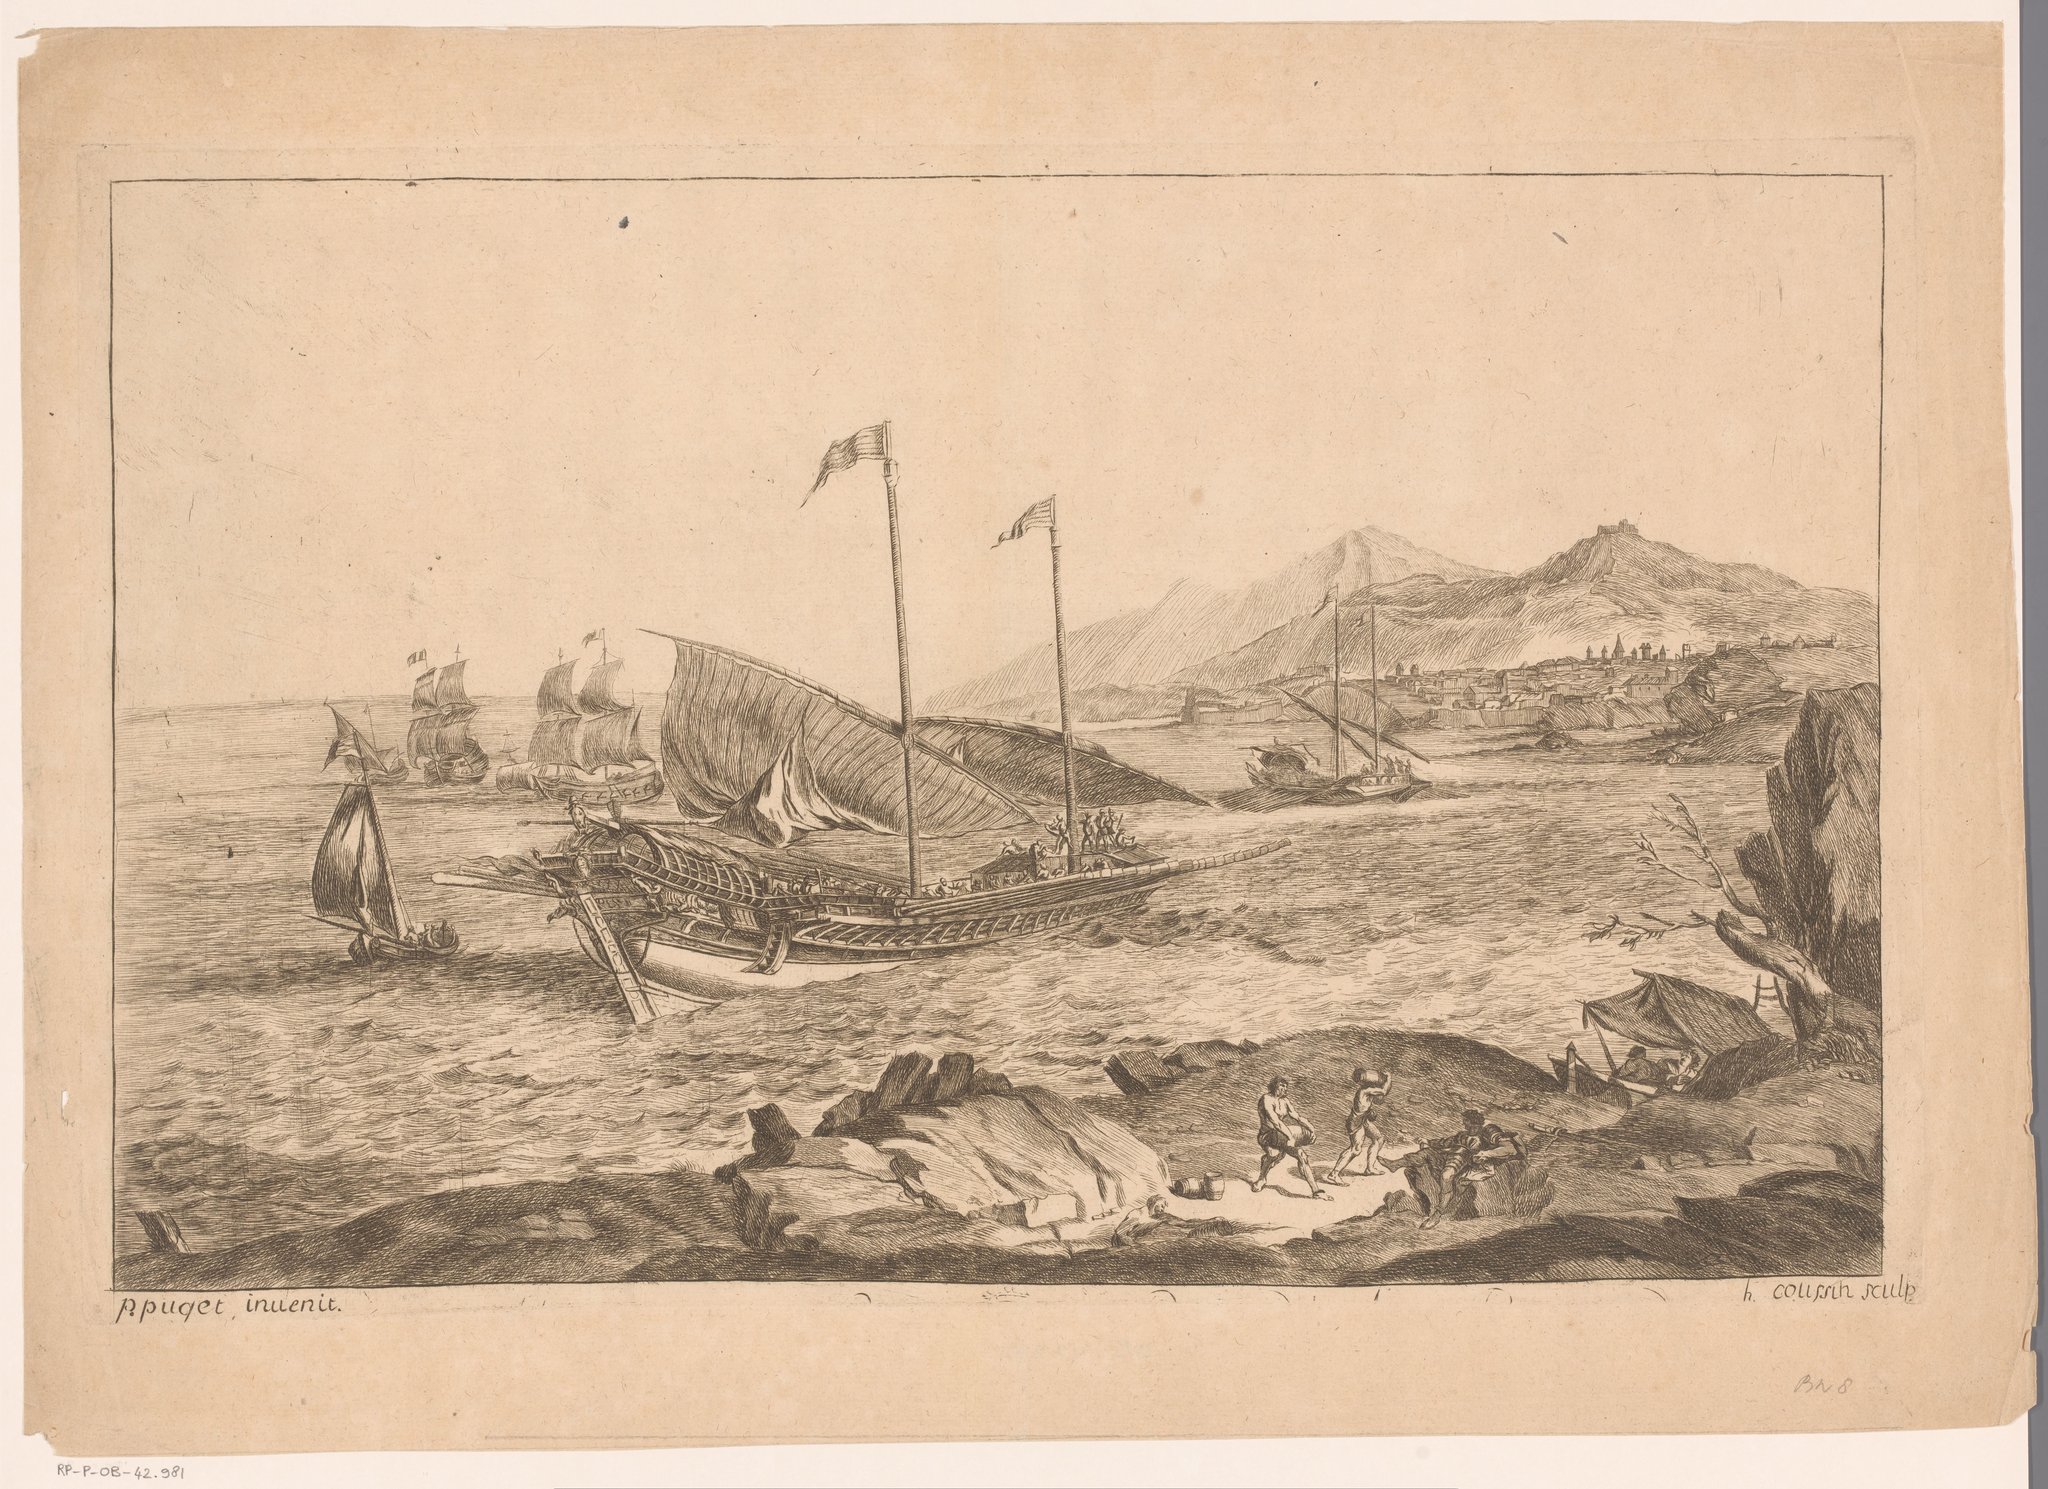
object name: print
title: Zeegezicht met schepen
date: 1708-1779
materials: paper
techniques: etching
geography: france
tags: sailing-ship, sailing-boat, ships (in general), sea (seascape)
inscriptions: collector's mark: Lugt 2228